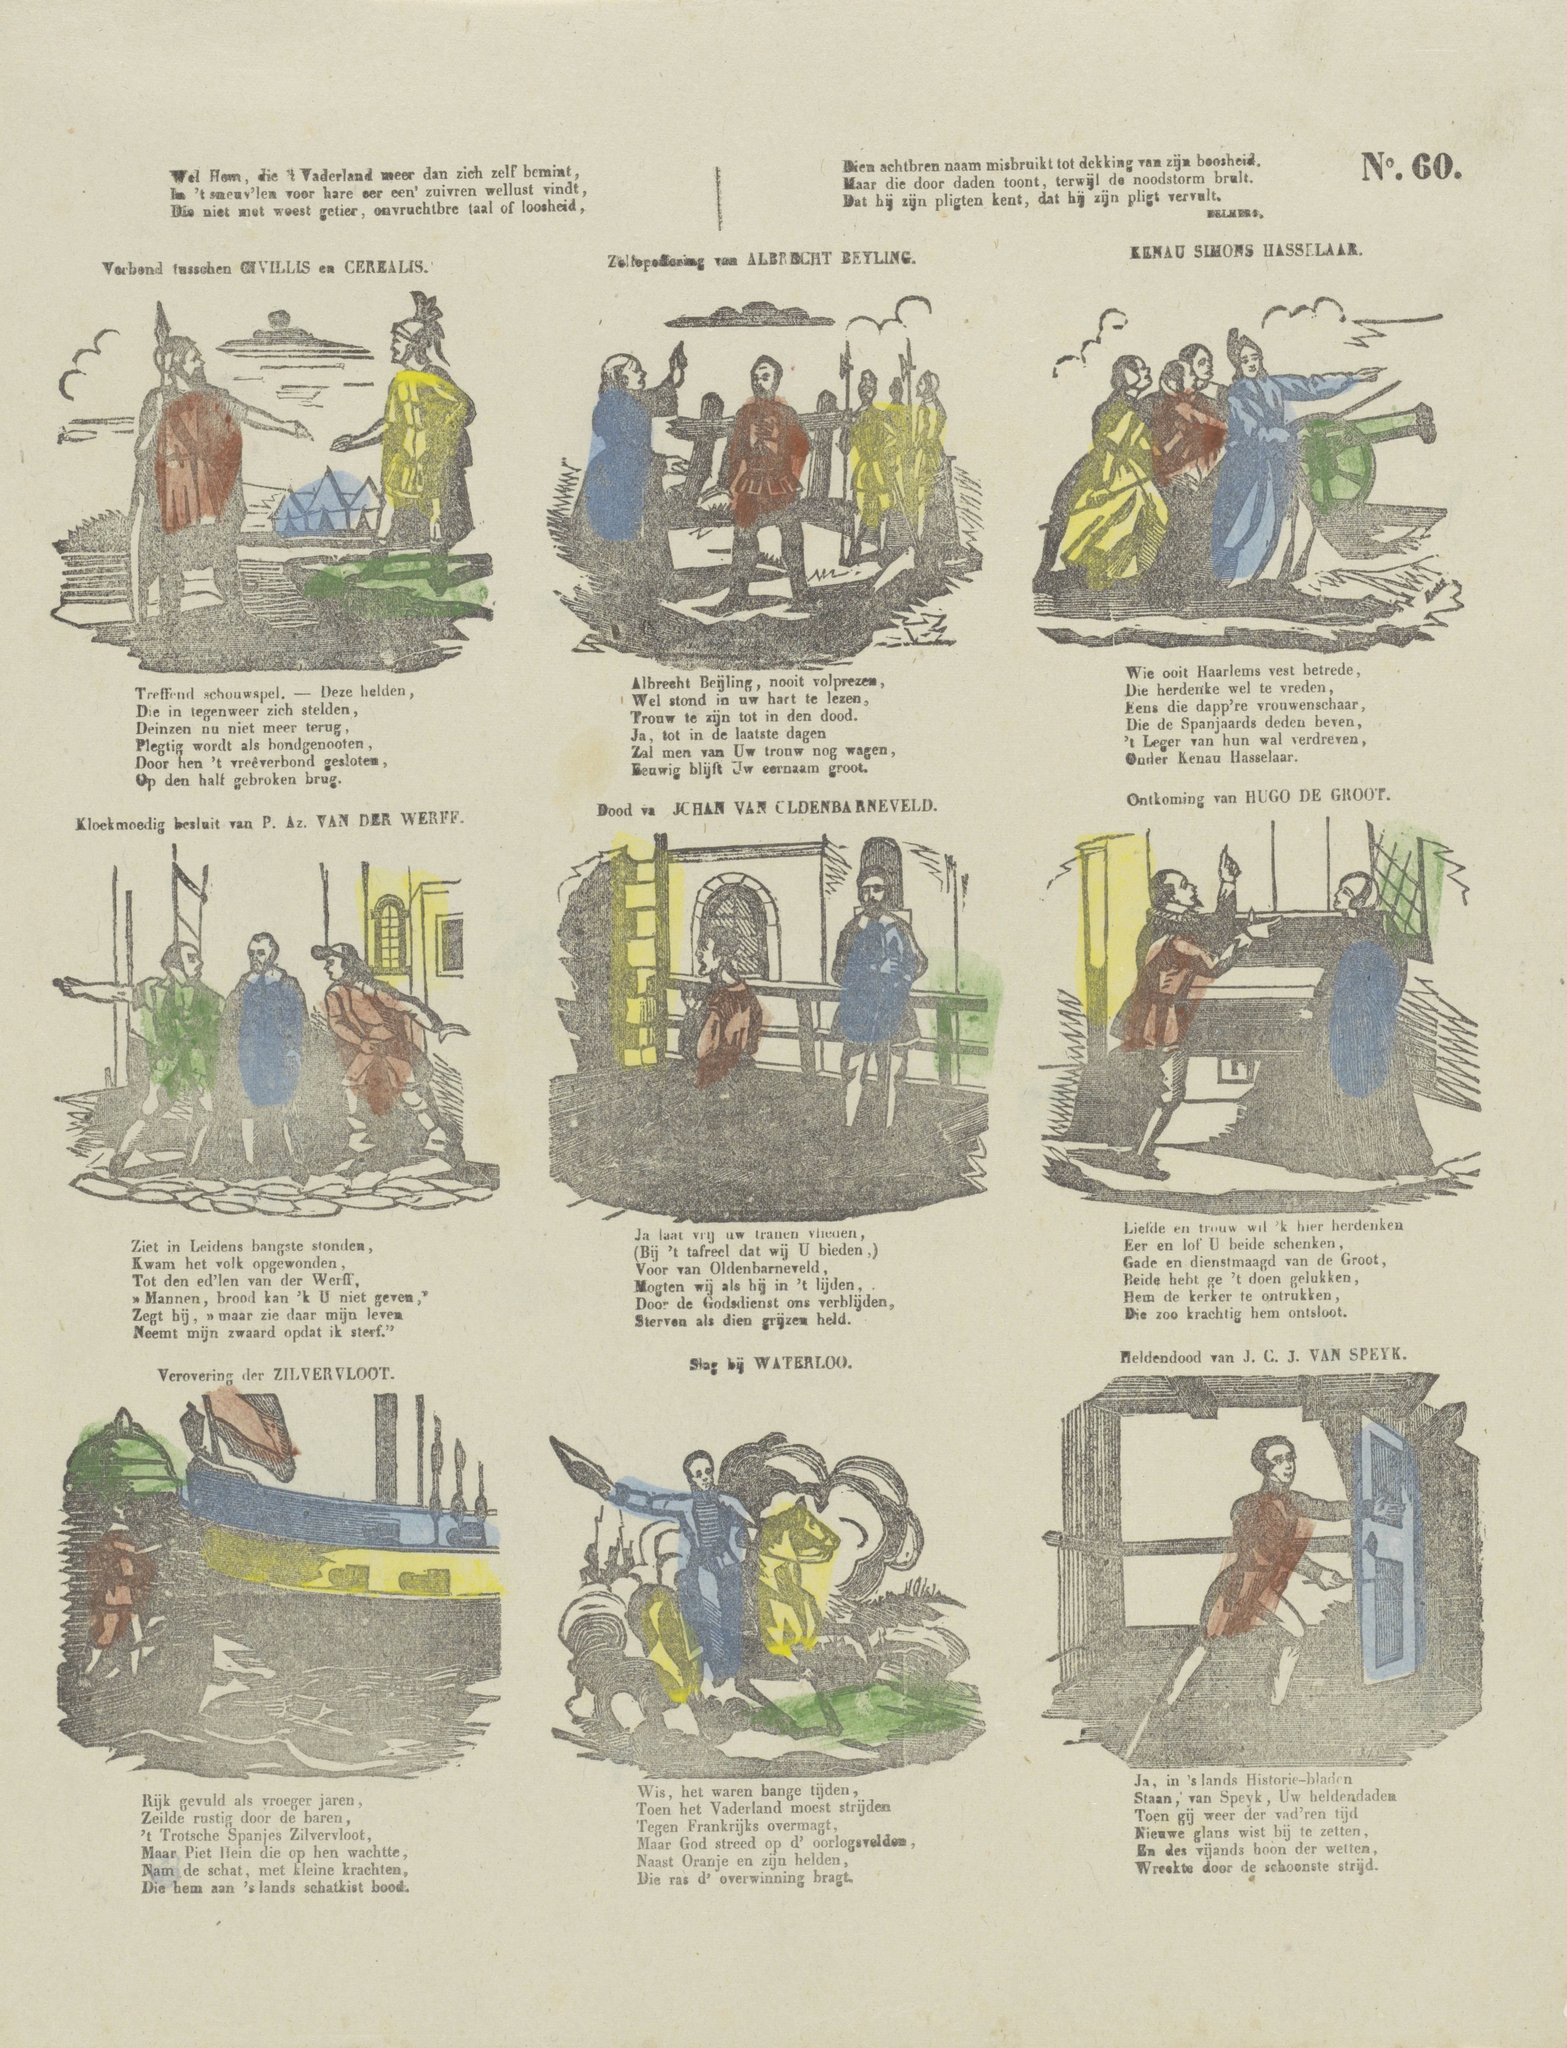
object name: print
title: Wel hem, die 't vaderland meer dan zich zelv' bemint, / In 't sneuv'len voor hare eer een' zuivren wellust vindt [(...)]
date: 1850-1870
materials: paper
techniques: colour, letterpress printing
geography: netherlands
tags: delft, hugo de groot, amsterdam, antwerp, jan van speyk, the hague, johan van oldenbarnevelt, mayor, history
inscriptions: collector's mark: Lugt 2760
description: Blad met 9 voorstellingen van figuren en taferelen uit de vaderlandse geschiedenis. Onder elke afbeelding een zesregelig vers. Genummerd rechtsboven: No. 60.